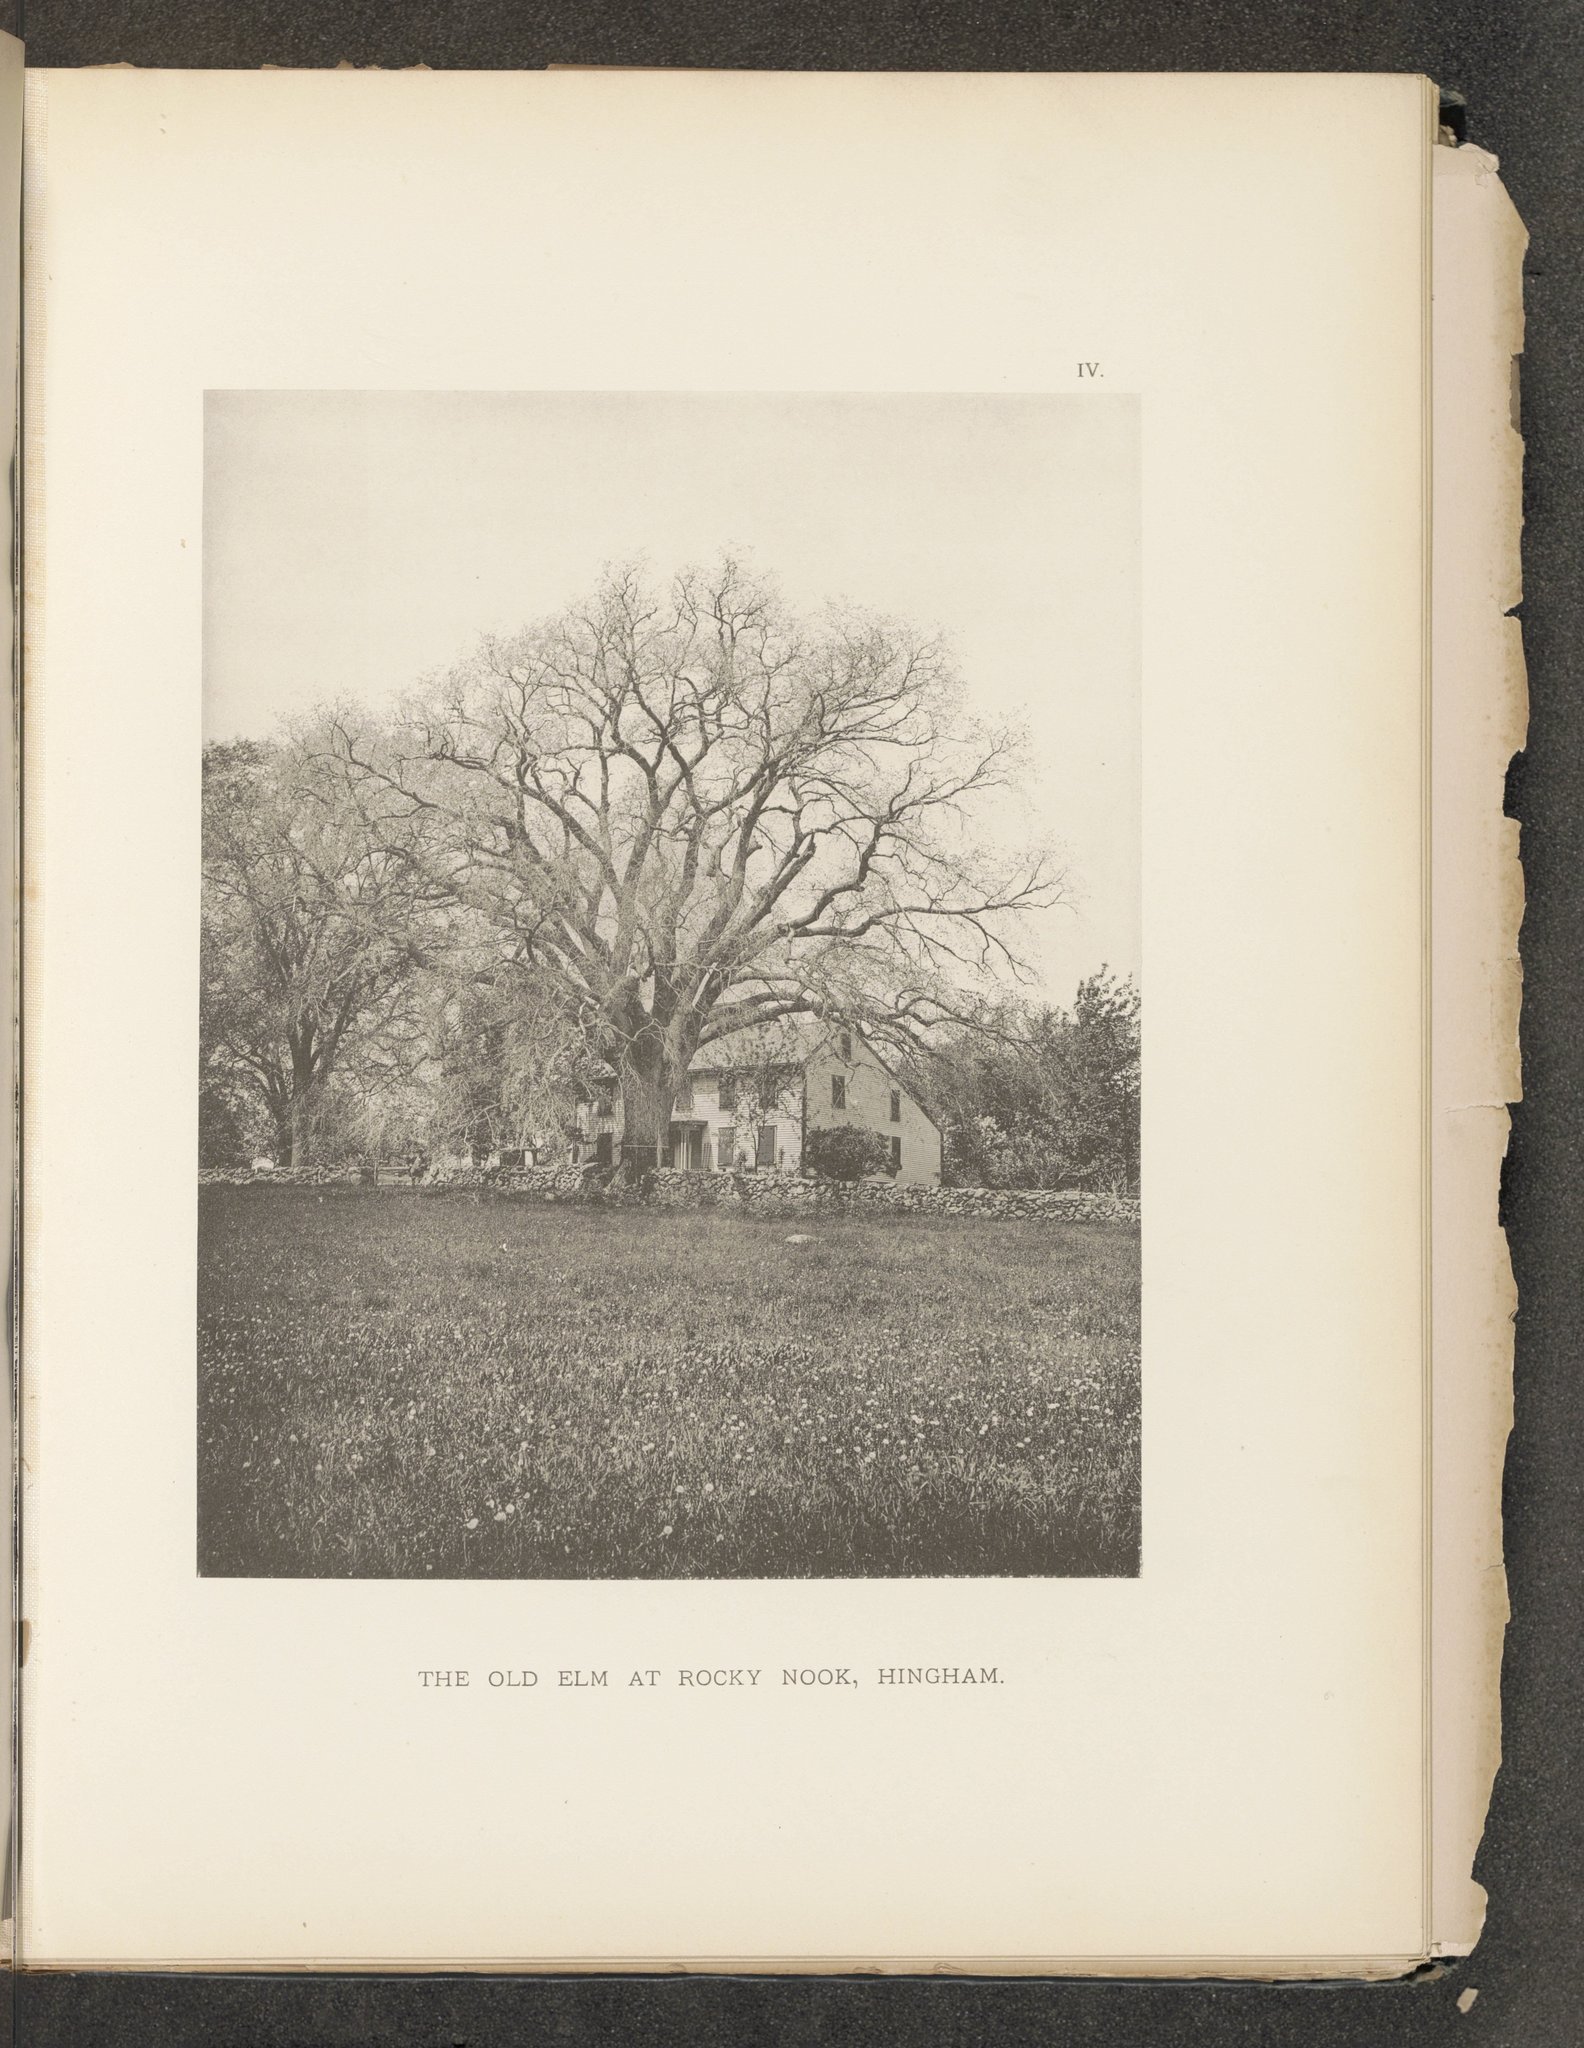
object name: page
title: The old elm at Rocky Nook, Hingham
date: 1880-1890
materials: paper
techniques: photograph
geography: hingham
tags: trees: elm, façade (of house or building)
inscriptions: number: ‘IV.’